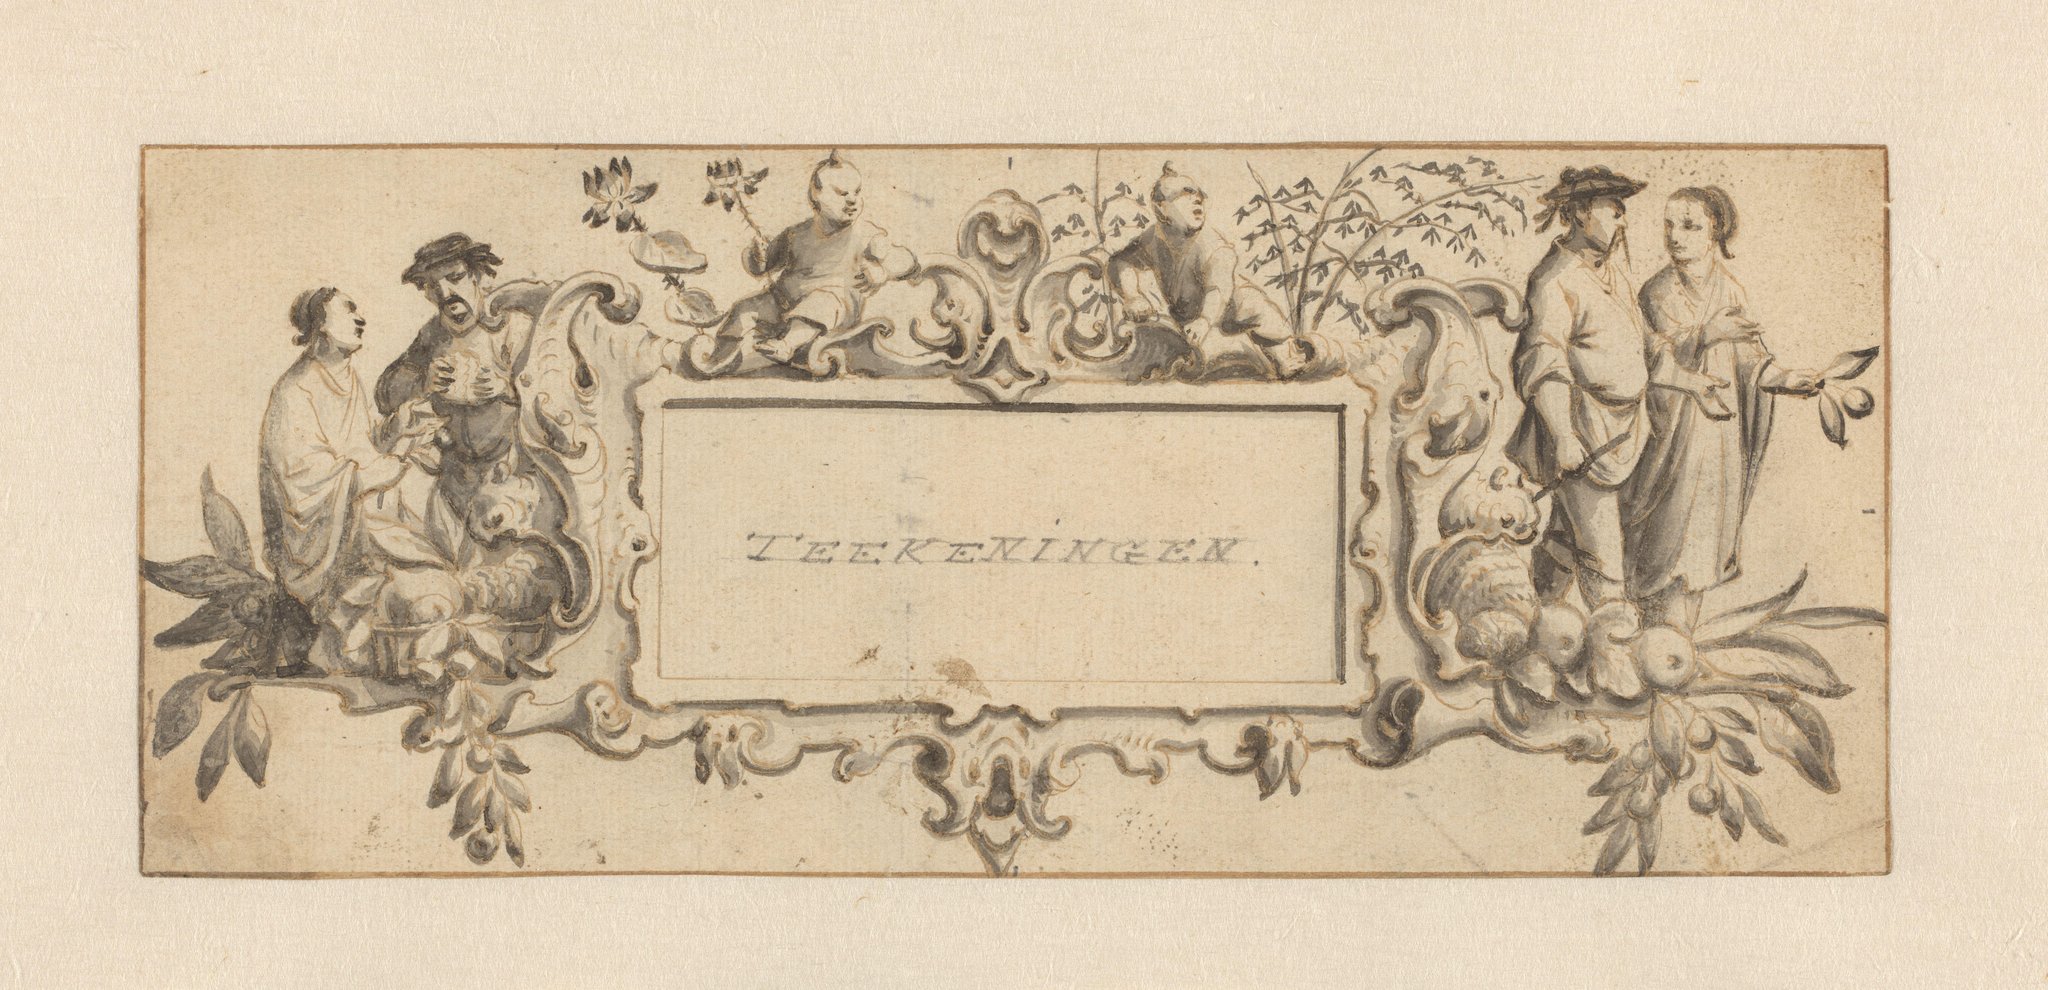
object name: drawing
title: Cartouche met oosterse figuren en florale motieven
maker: pieter jansz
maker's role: draughtsman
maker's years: 1602-1672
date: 1664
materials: graphite, ink, paper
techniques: brush, pen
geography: netherlands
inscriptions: inscription: ‘tekeningen’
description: Cartouche ontwerp voor: Imperii Sinarum nova descriptio, Atlas Blaeu vol. IX, 1664.